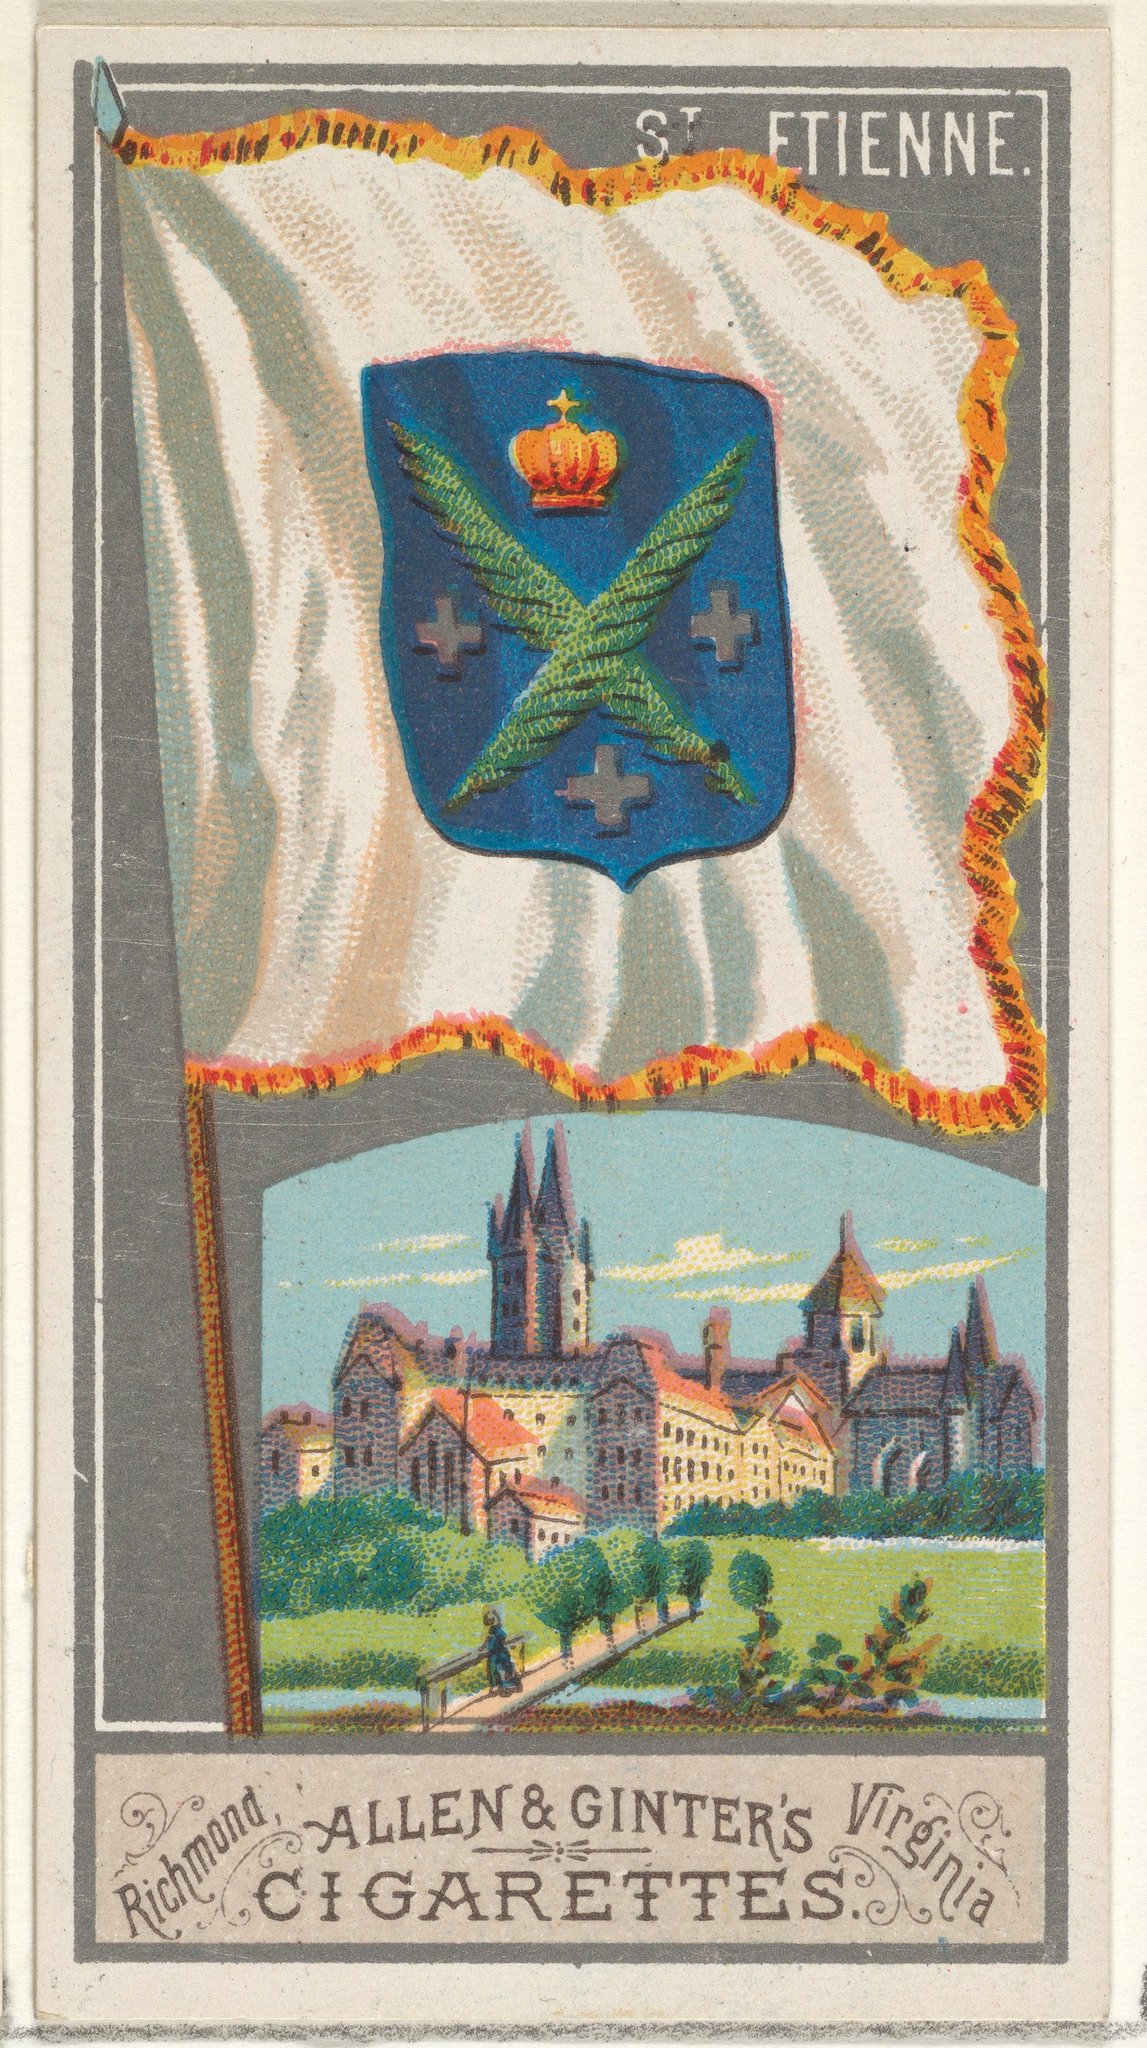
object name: print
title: St. Etienne, from the City Flags series (N6) for Allen & Ginter Cigarettes Brands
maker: allen & ginter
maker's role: publisher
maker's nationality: american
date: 1887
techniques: color lithograph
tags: coat of arms,flags